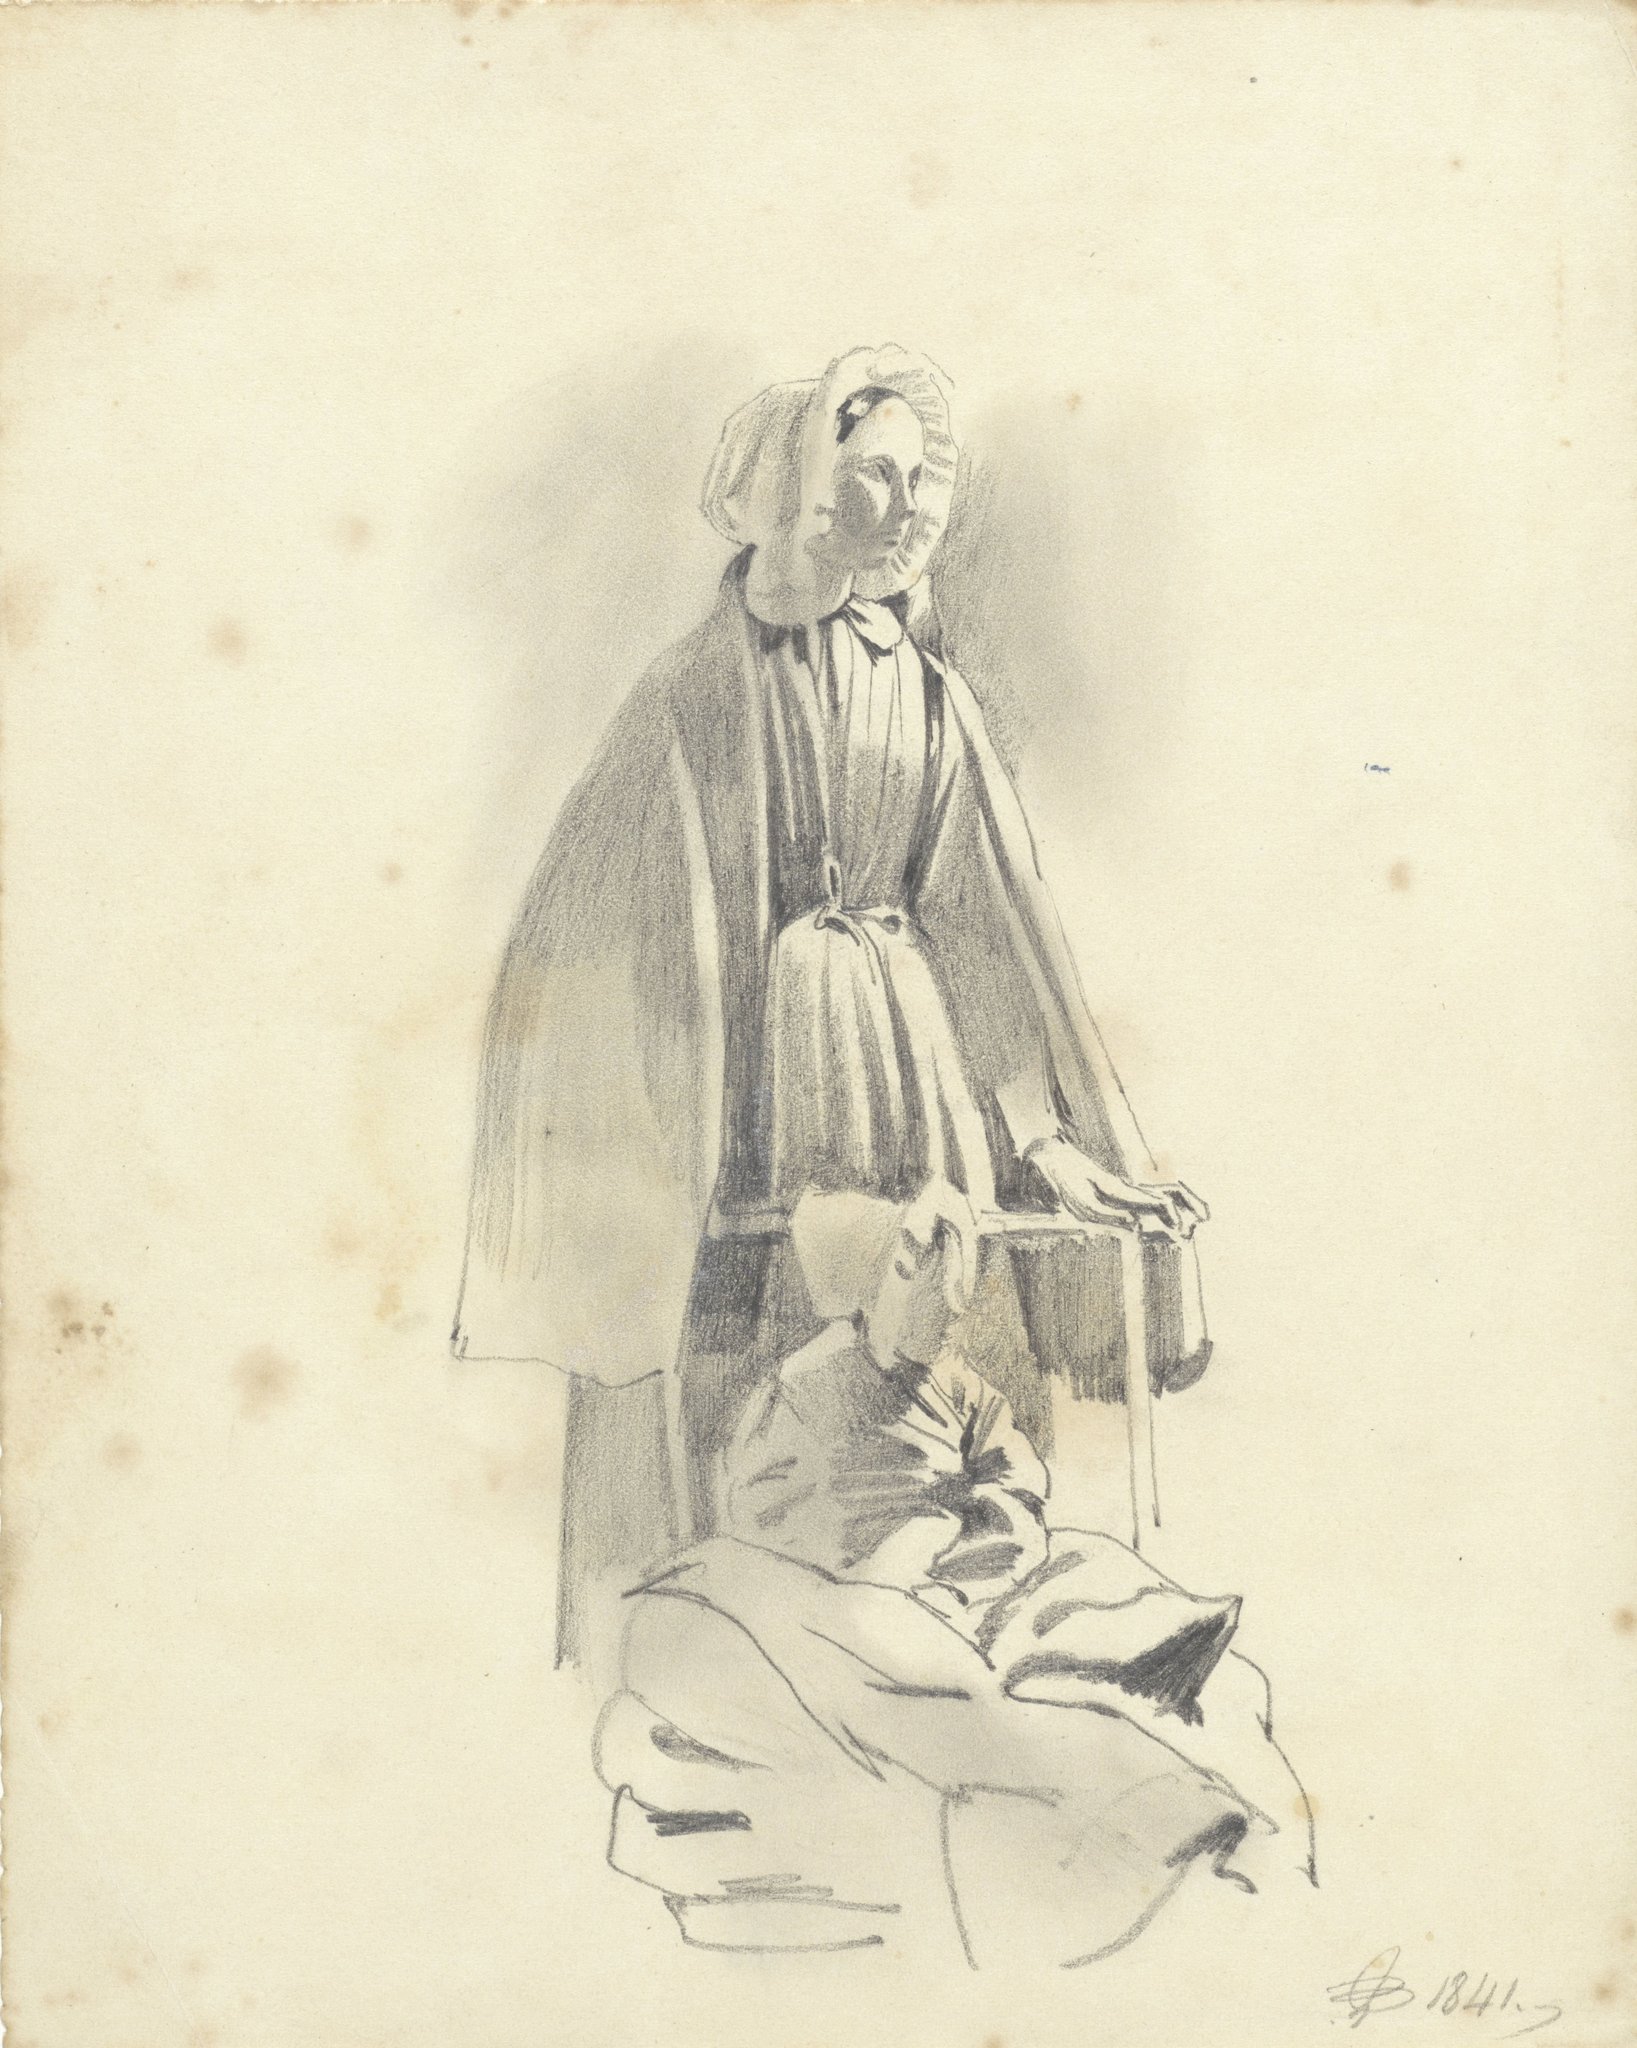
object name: drawing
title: Vrouw met kind in kinderwagen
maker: pieter van loon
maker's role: draughtsman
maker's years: 1801-1873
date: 1841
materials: paper, pencil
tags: baby-carriage, pram, perambulator